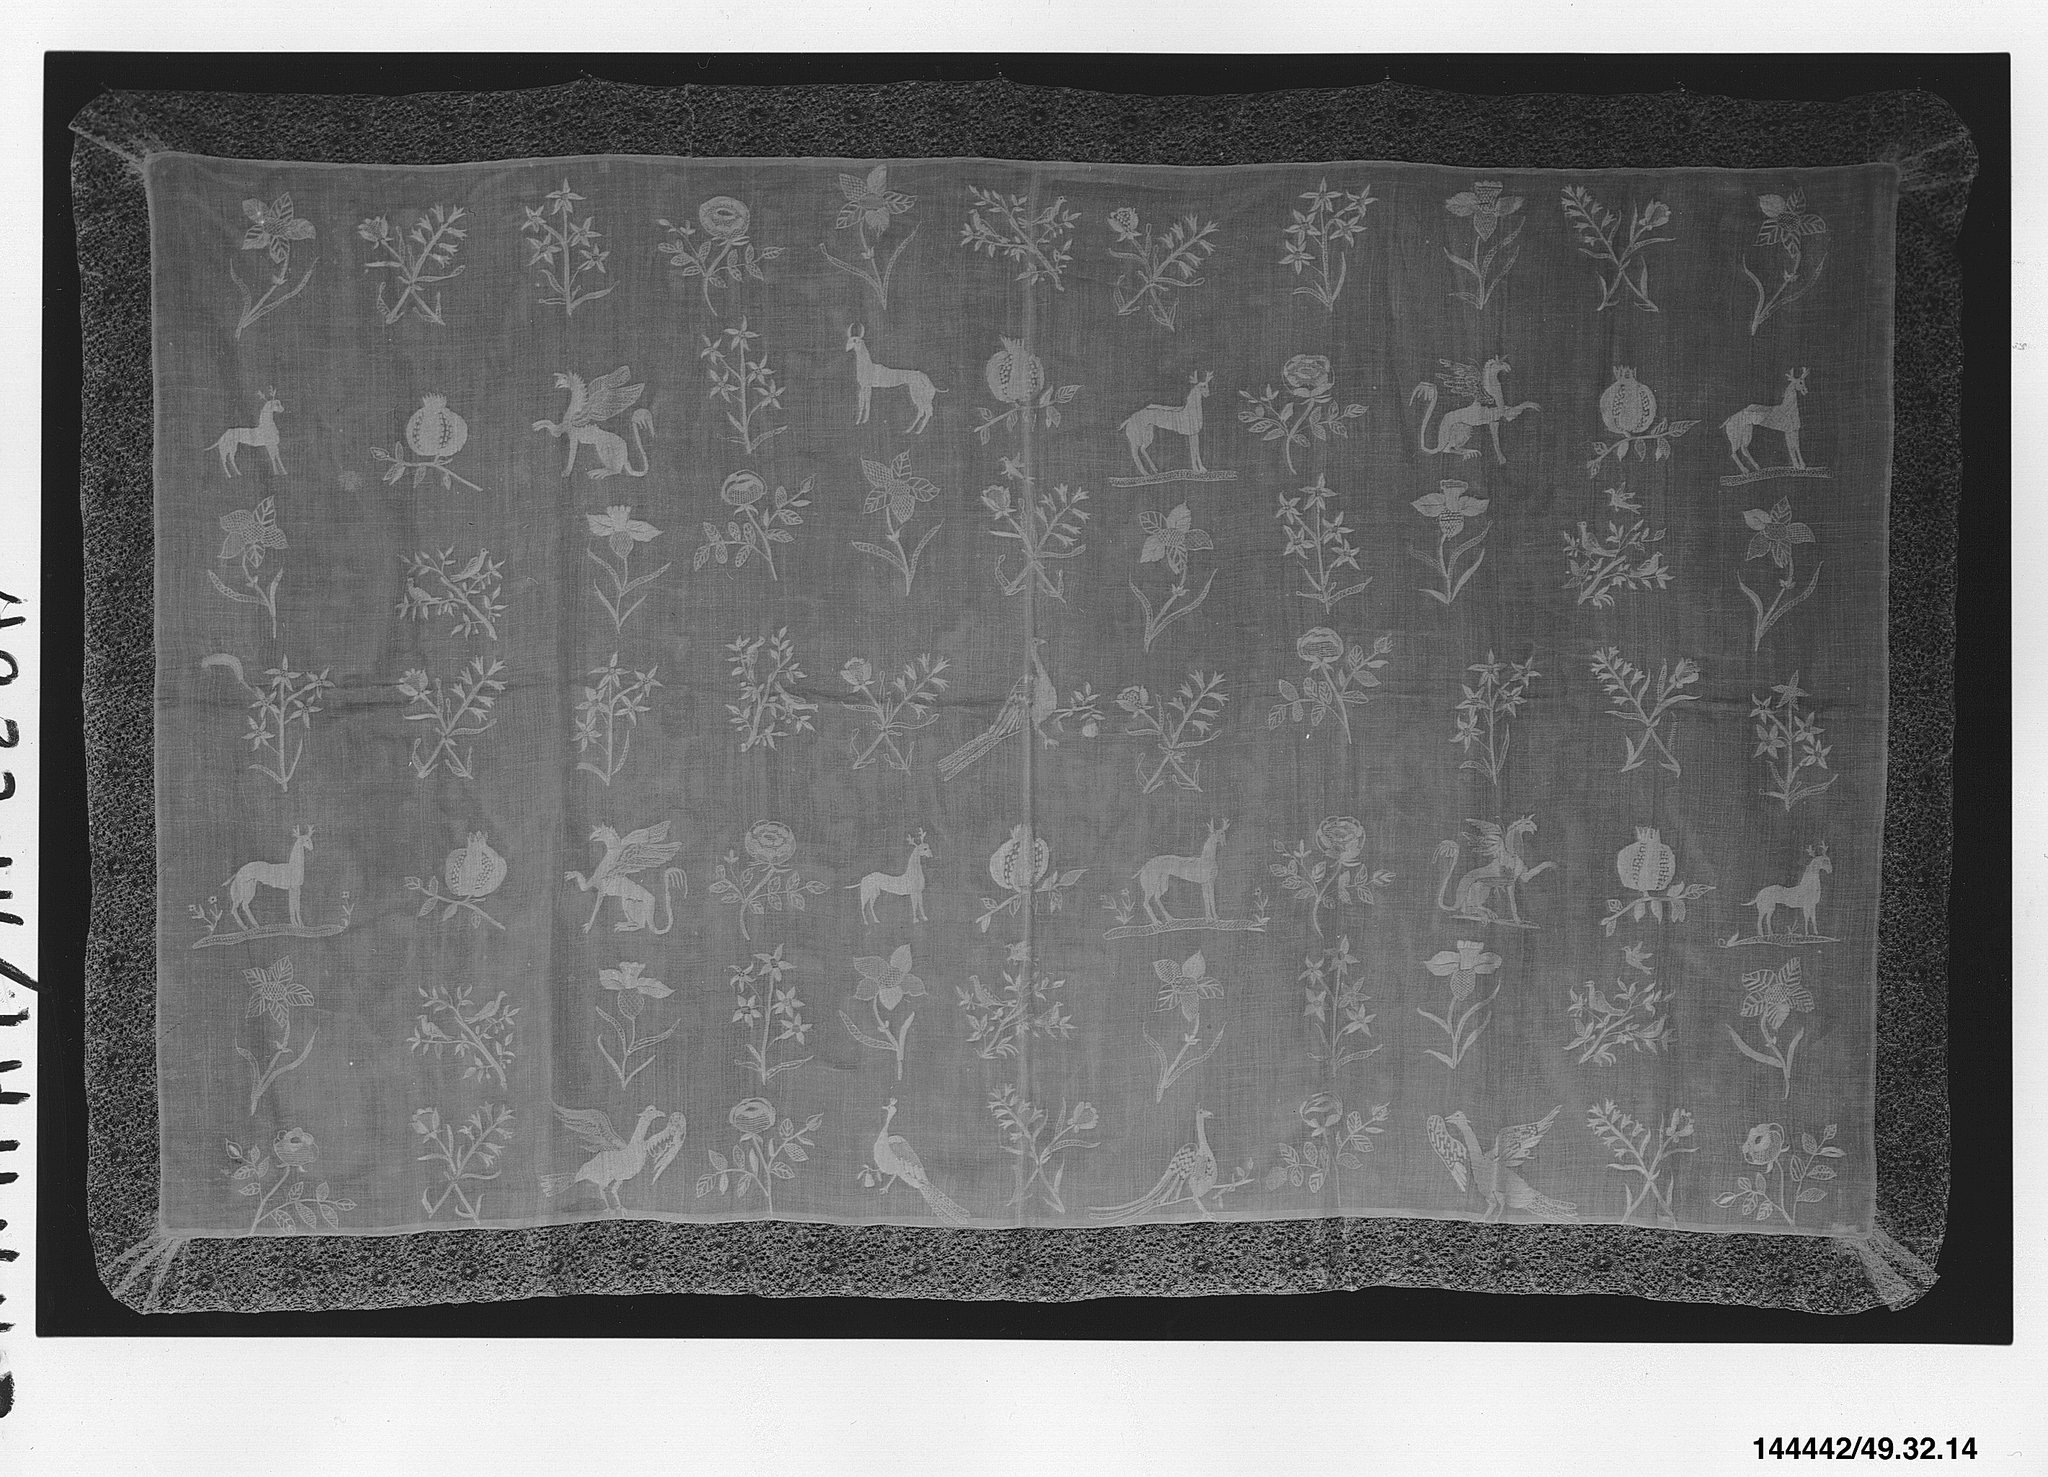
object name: cover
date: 1701-1800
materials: linen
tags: animals,birds,griffins